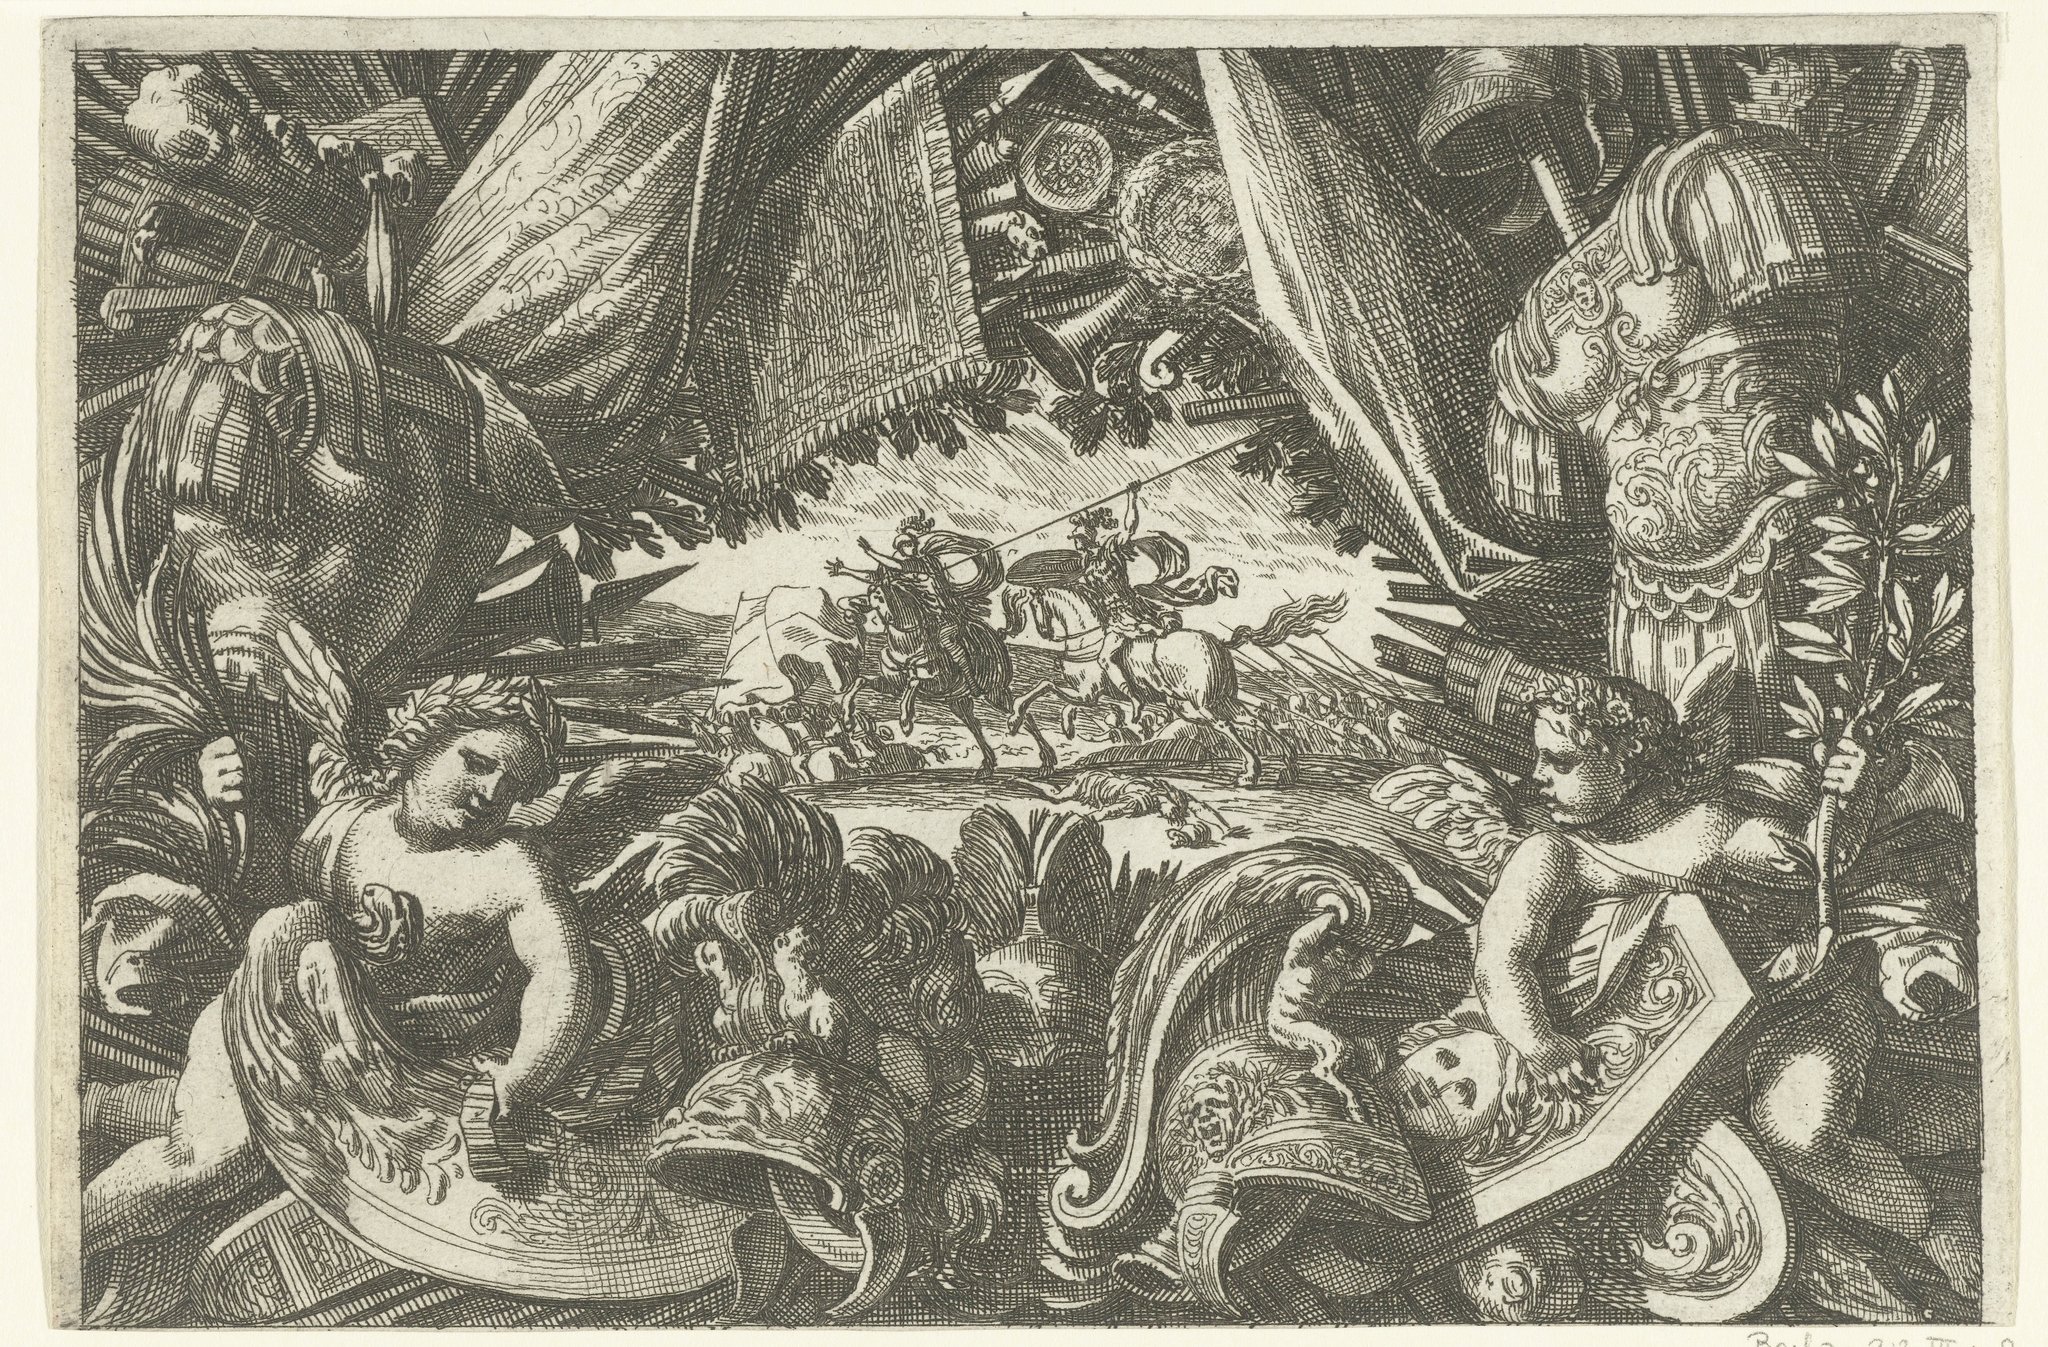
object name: ornament print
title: Wapentrofee in vorm van cartouche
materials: paper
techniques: etching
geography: france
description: In het midden is een slagveld te zien. Blad 6 uit serie van 6.